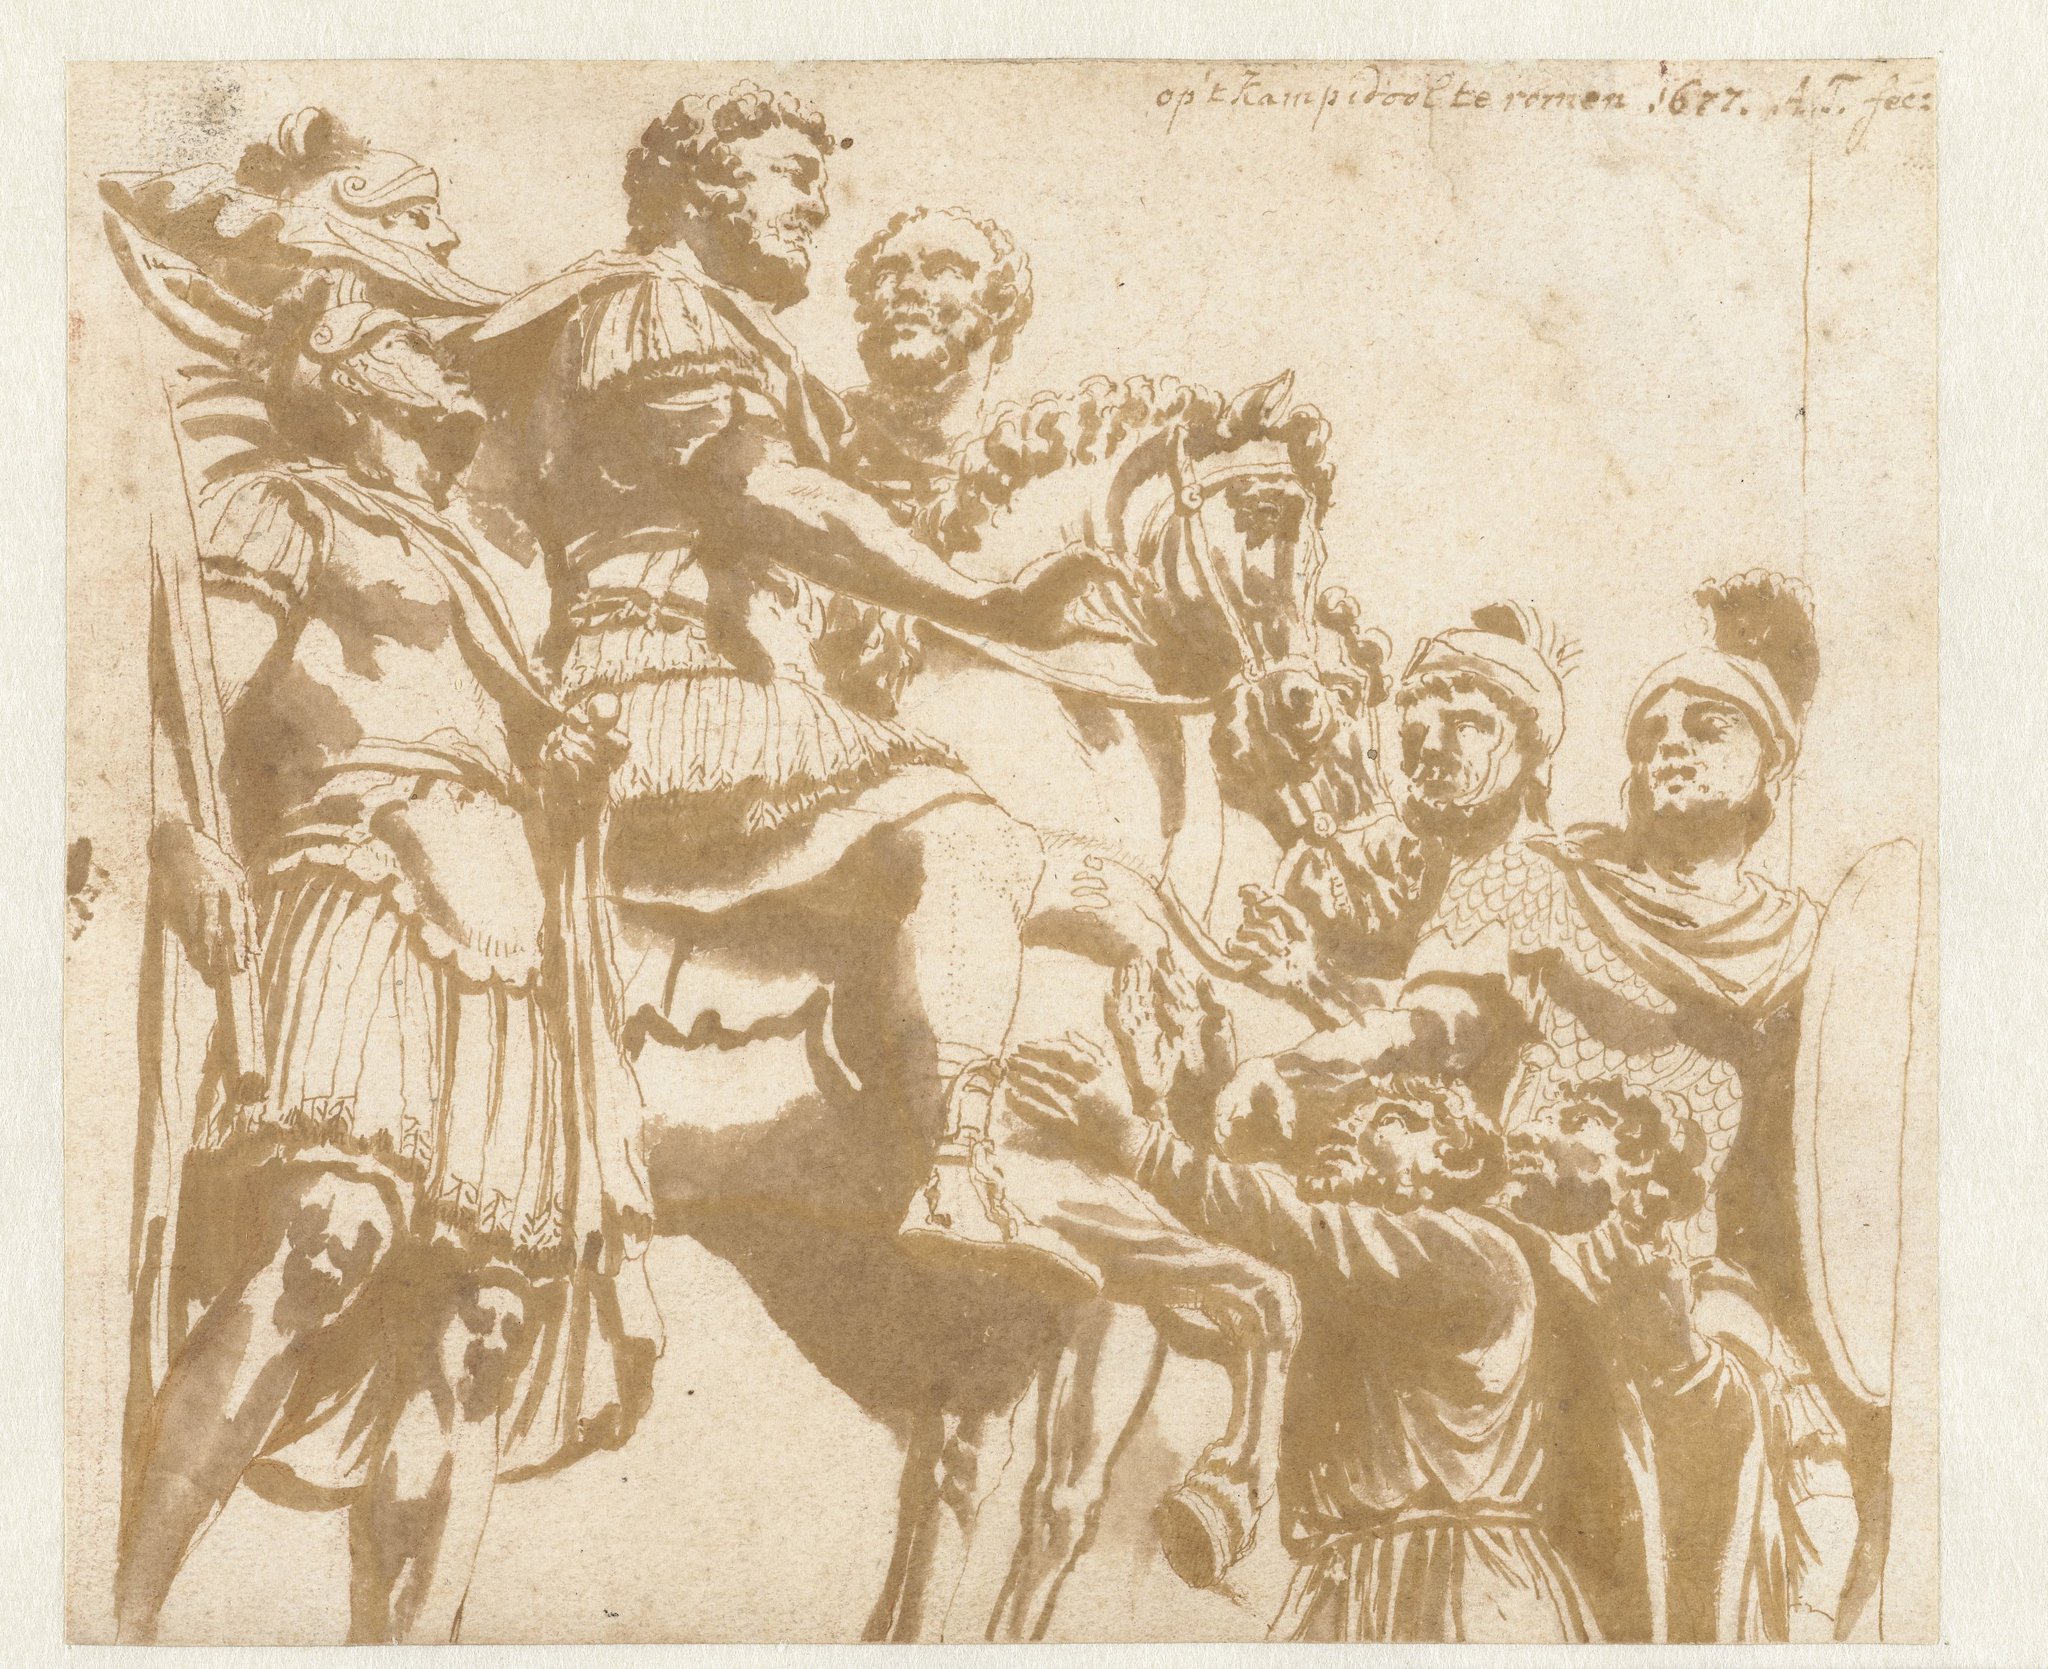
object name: drawing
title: Reliëf met Marcus Aurelius en de overwonnen barbaren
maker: augustinus terwesten (i)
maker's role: draughtsman, painter, print maker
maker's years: 1649-1711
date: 1677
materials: chalk, ink, paper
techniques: brush, pen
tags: piece of sculpture, reproduction of a piece of sculpture, triumph of marcus aurelius, the roman emperor